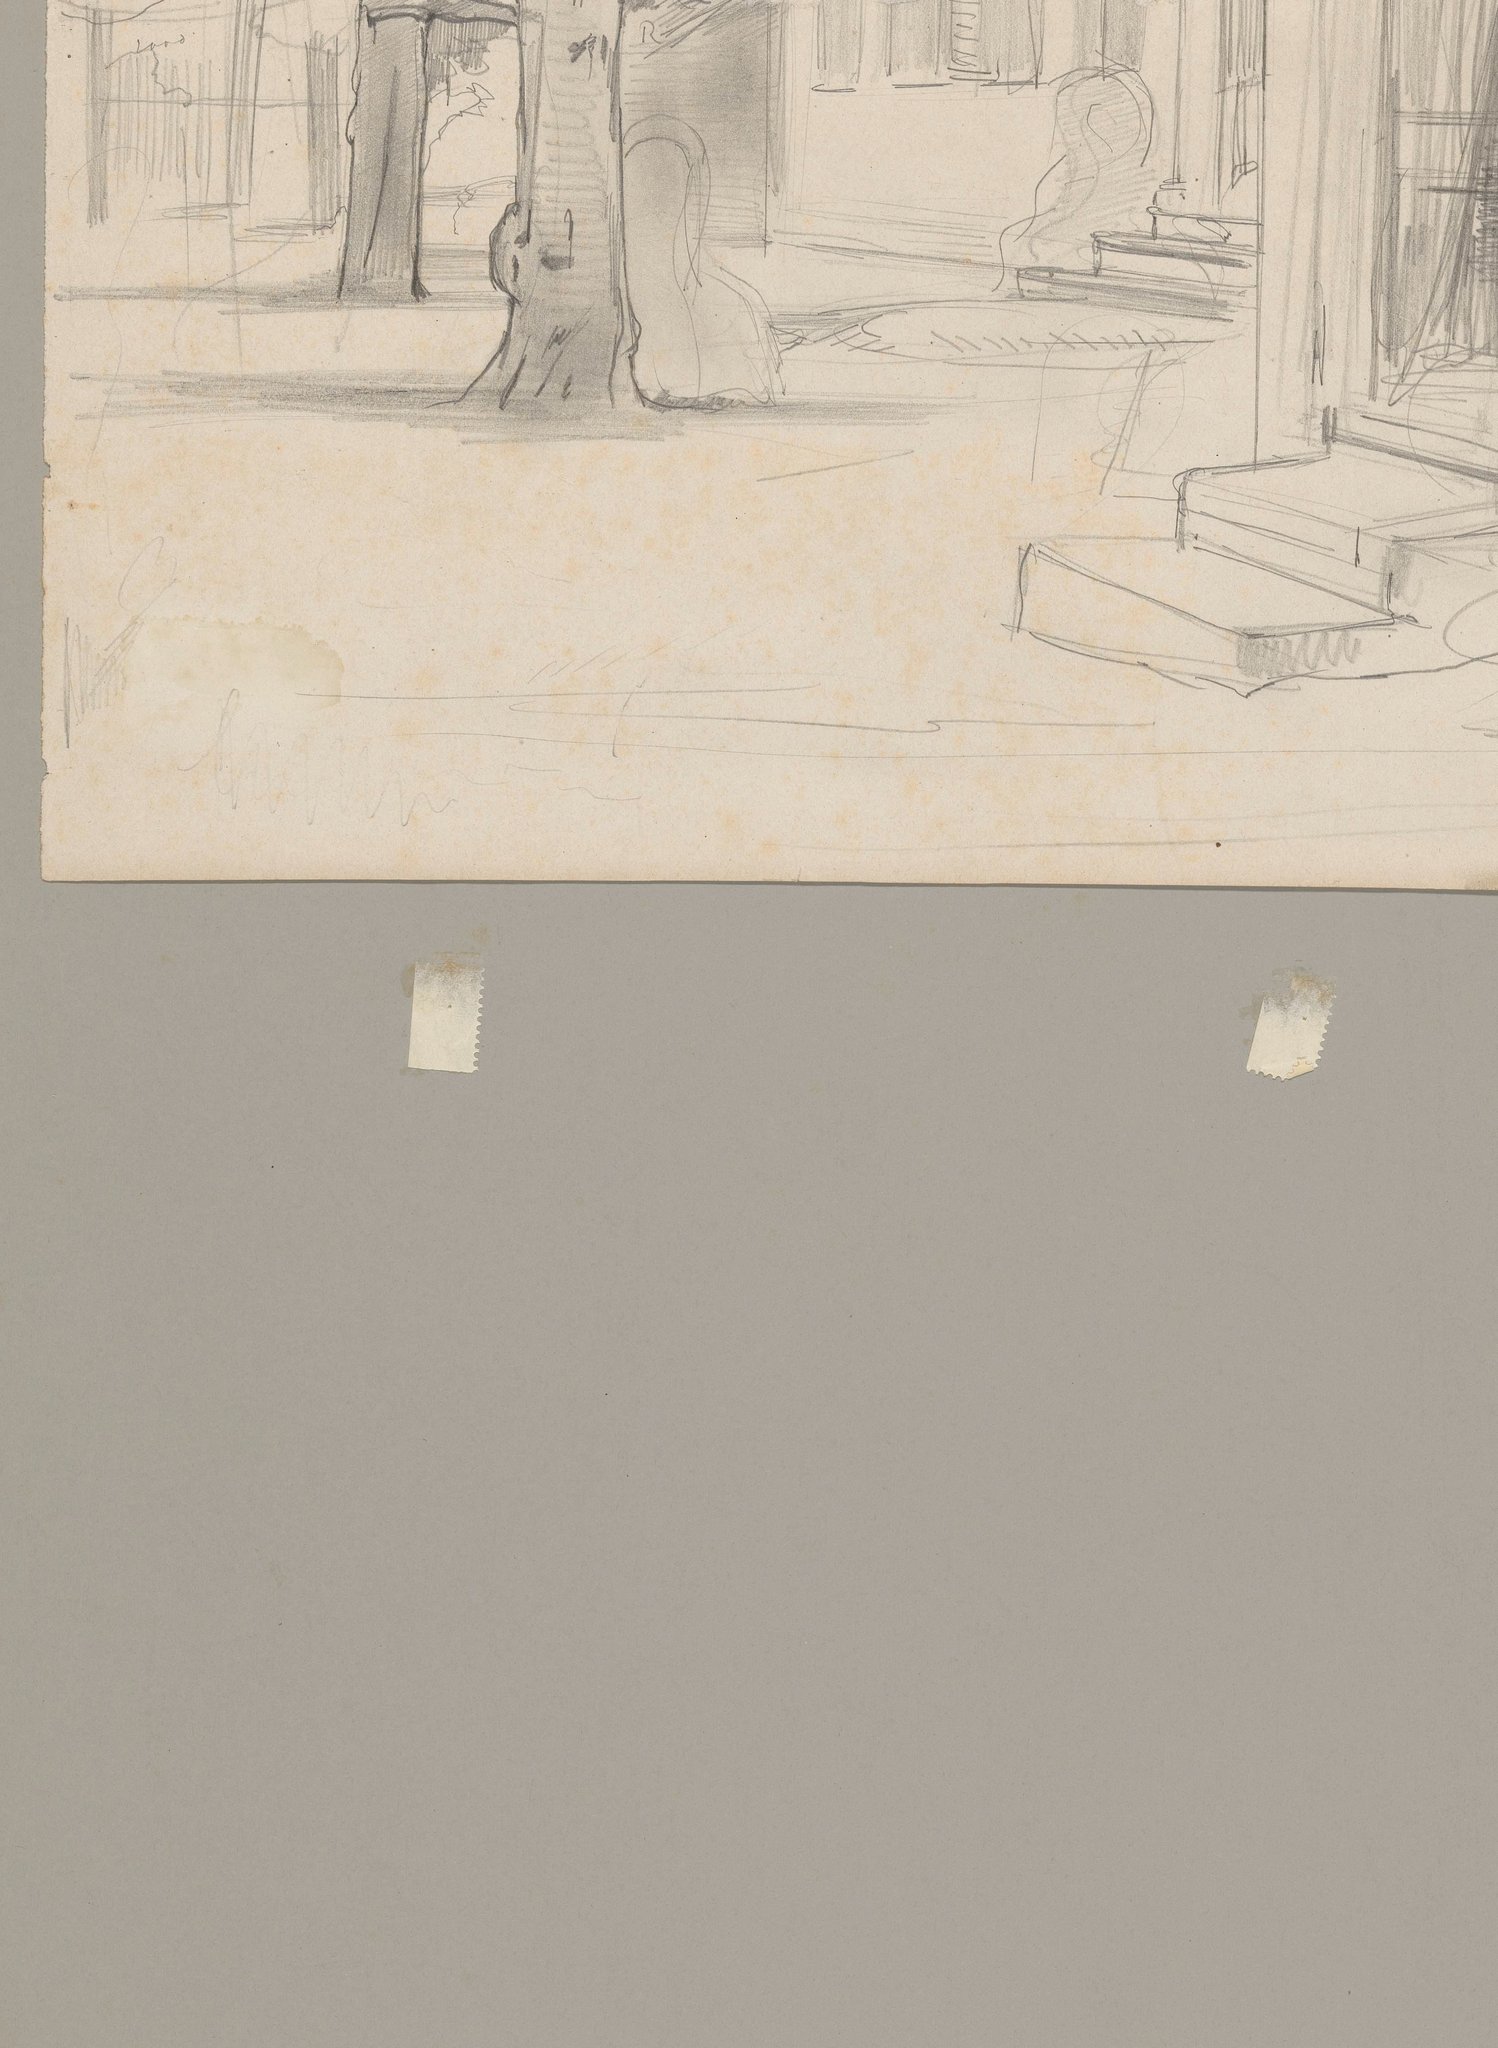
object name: drawing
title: Binnenplaats met bomen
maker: august allebé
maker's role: draughtsman, print maker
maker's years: 1838-1927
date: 1860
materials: paper, pencil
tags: trees, village square, place